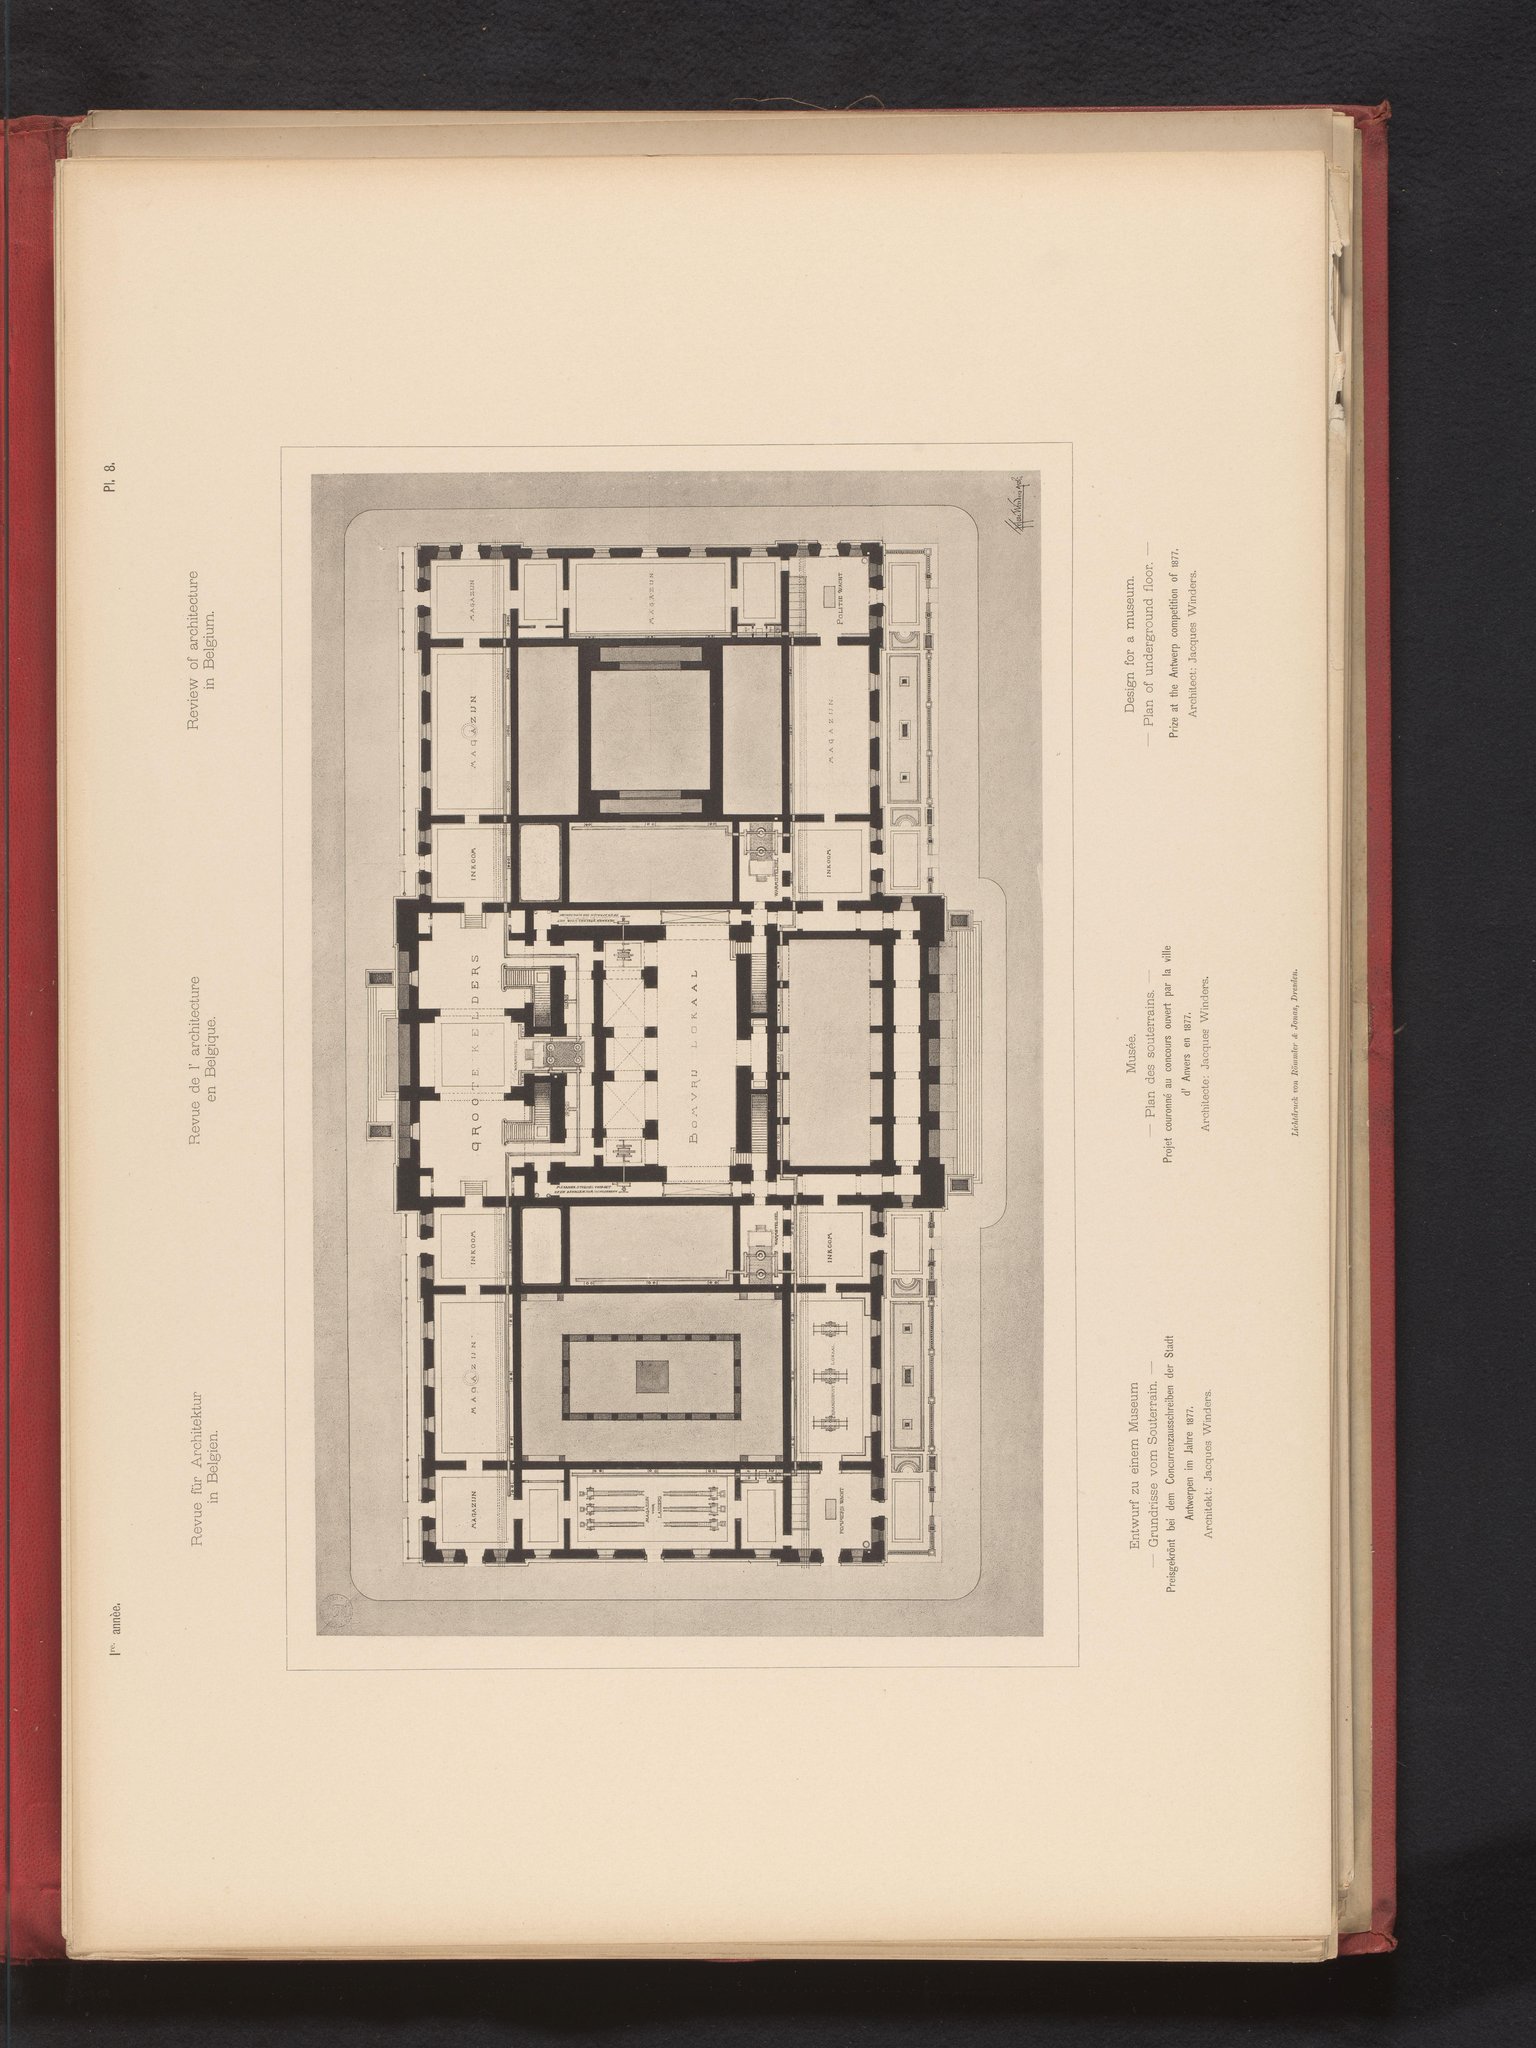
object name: photomechanical print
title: Musée - Plan des souterrains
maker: jean-jacques winders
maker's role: architect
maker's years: 1849-1936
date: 1888-1893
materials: paper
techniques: photograph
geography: dresden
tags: permanent exhibition, museum, plan ~ architecture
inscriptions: inscription: ‘1re. annèe.’, inscription: ‘Projet couronné au concours ouvert par la ville/ d'Anvers en 1877.’, number: ‘Pl. 8.’, inscription: ‘Prize at the Antwerp competition of 1877.’, inscription: ‘Preisgekrönt bei dem Concurrenzausschreiben der Stadt/ Antwerpen im Jahre 1877.’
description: Deze prent maakt deel uit van een omslag met 110 prenten op 90 bladen en 18 tekstbladen.